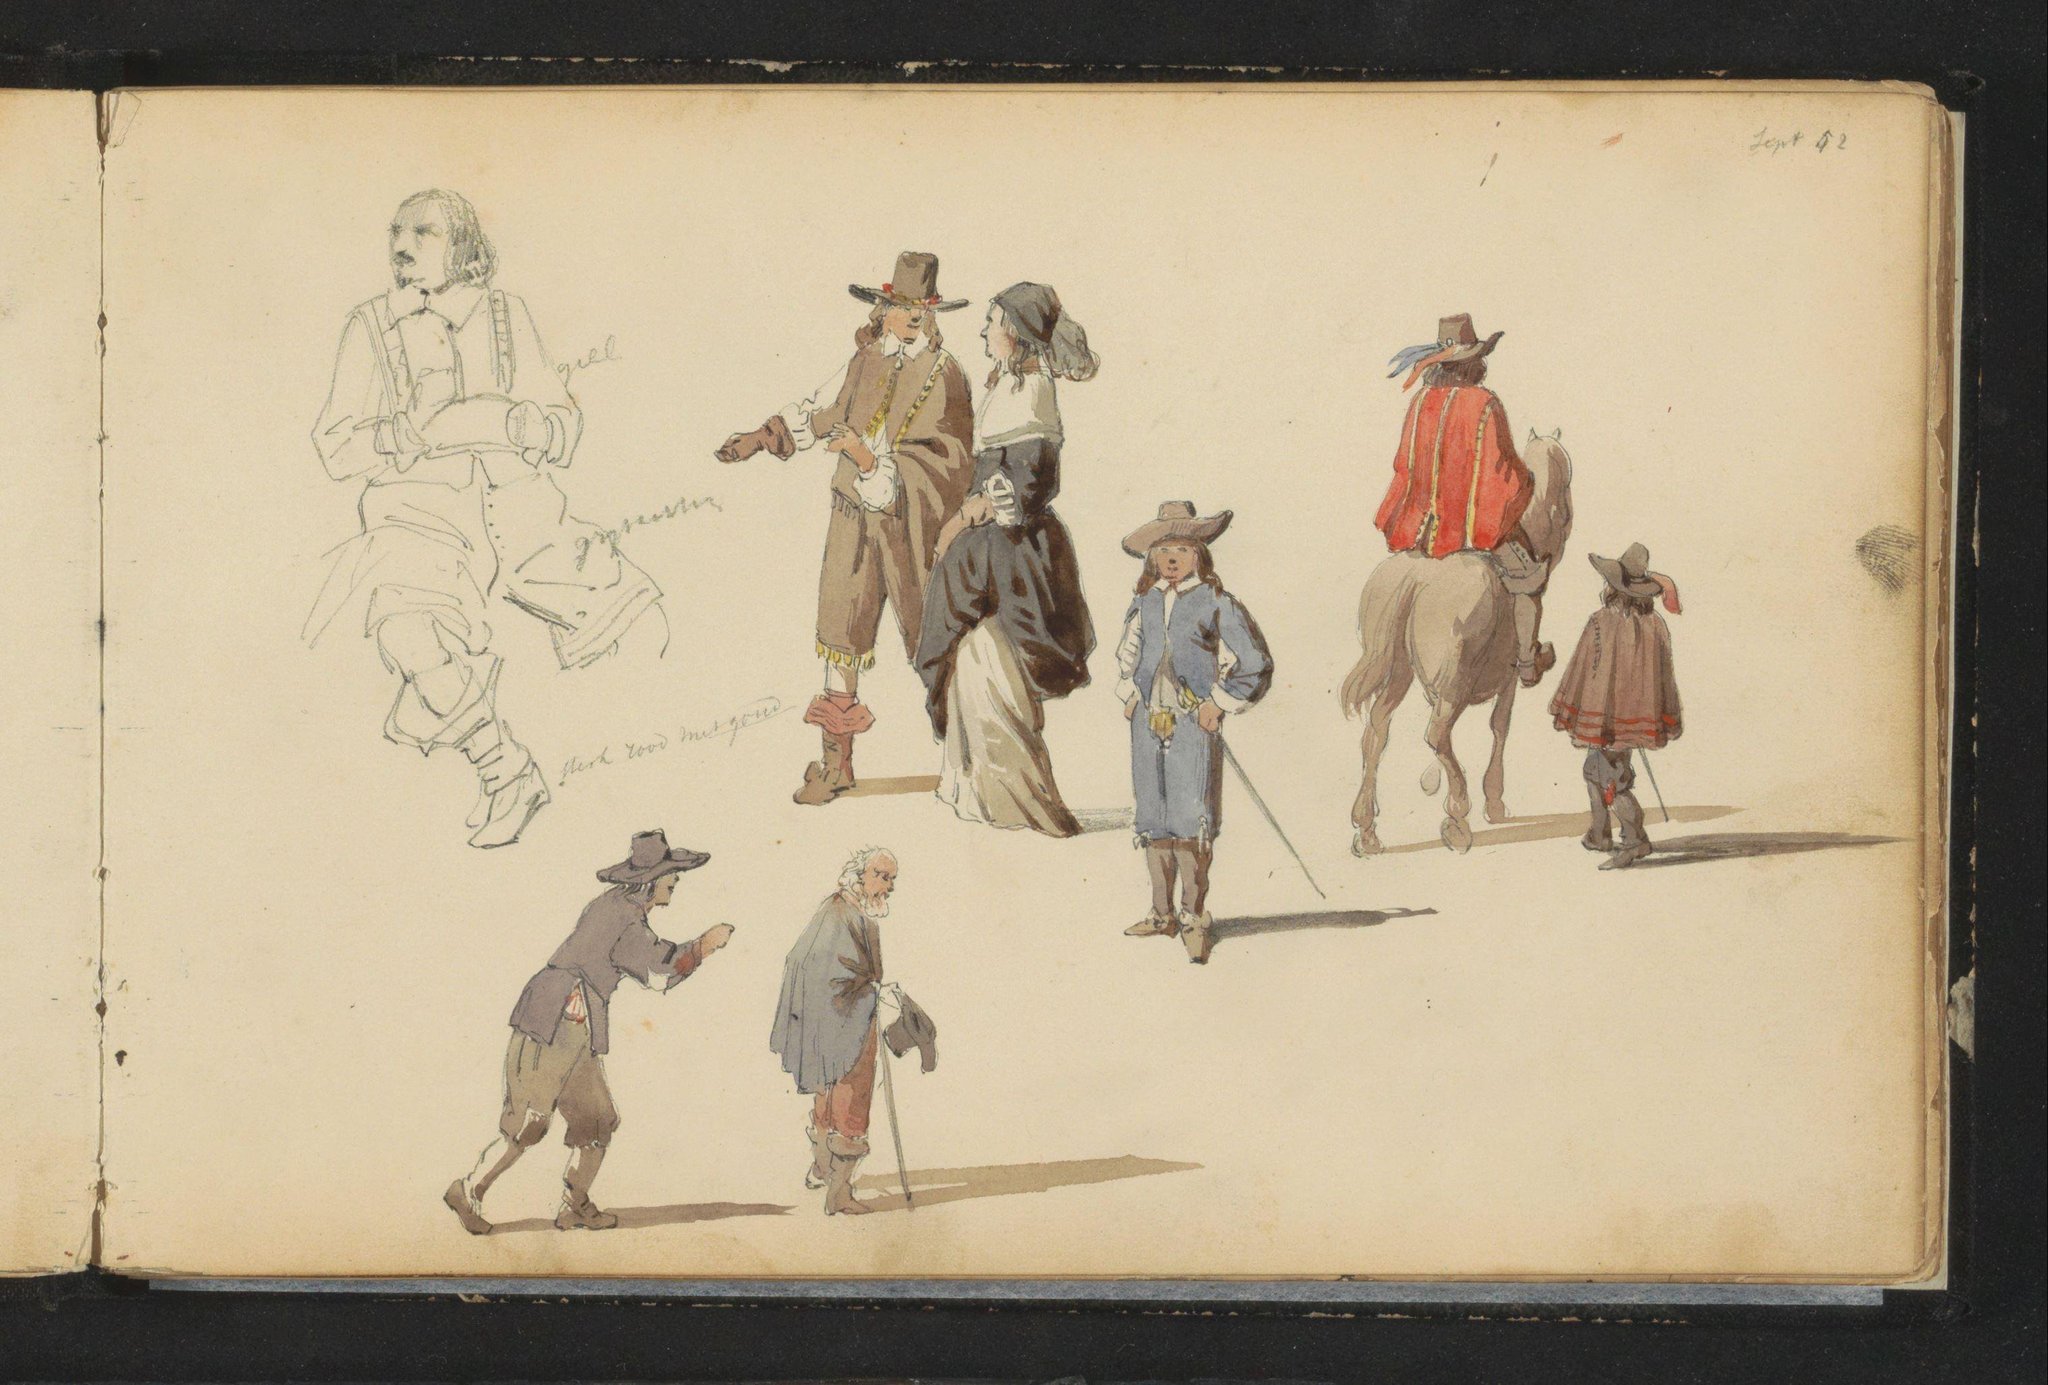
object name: sketchbook leaf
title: Figuren in zeventiende-eeuwse kleding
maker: cornelis springer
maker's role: draughtsman, painter, print maker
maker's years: 1817-1891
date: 1809-1852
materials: paper, pencil, watercolor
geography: netherlands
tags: adult woman, adult man, clothes, costume (+ women's clothes), clothes, costume (+ men's clothes), horse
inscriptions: date: ‘Sept 52’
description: Figuren in zeventiende-eeuwse kleding. Blad 11 uit een schetsboek met 91 bladen.